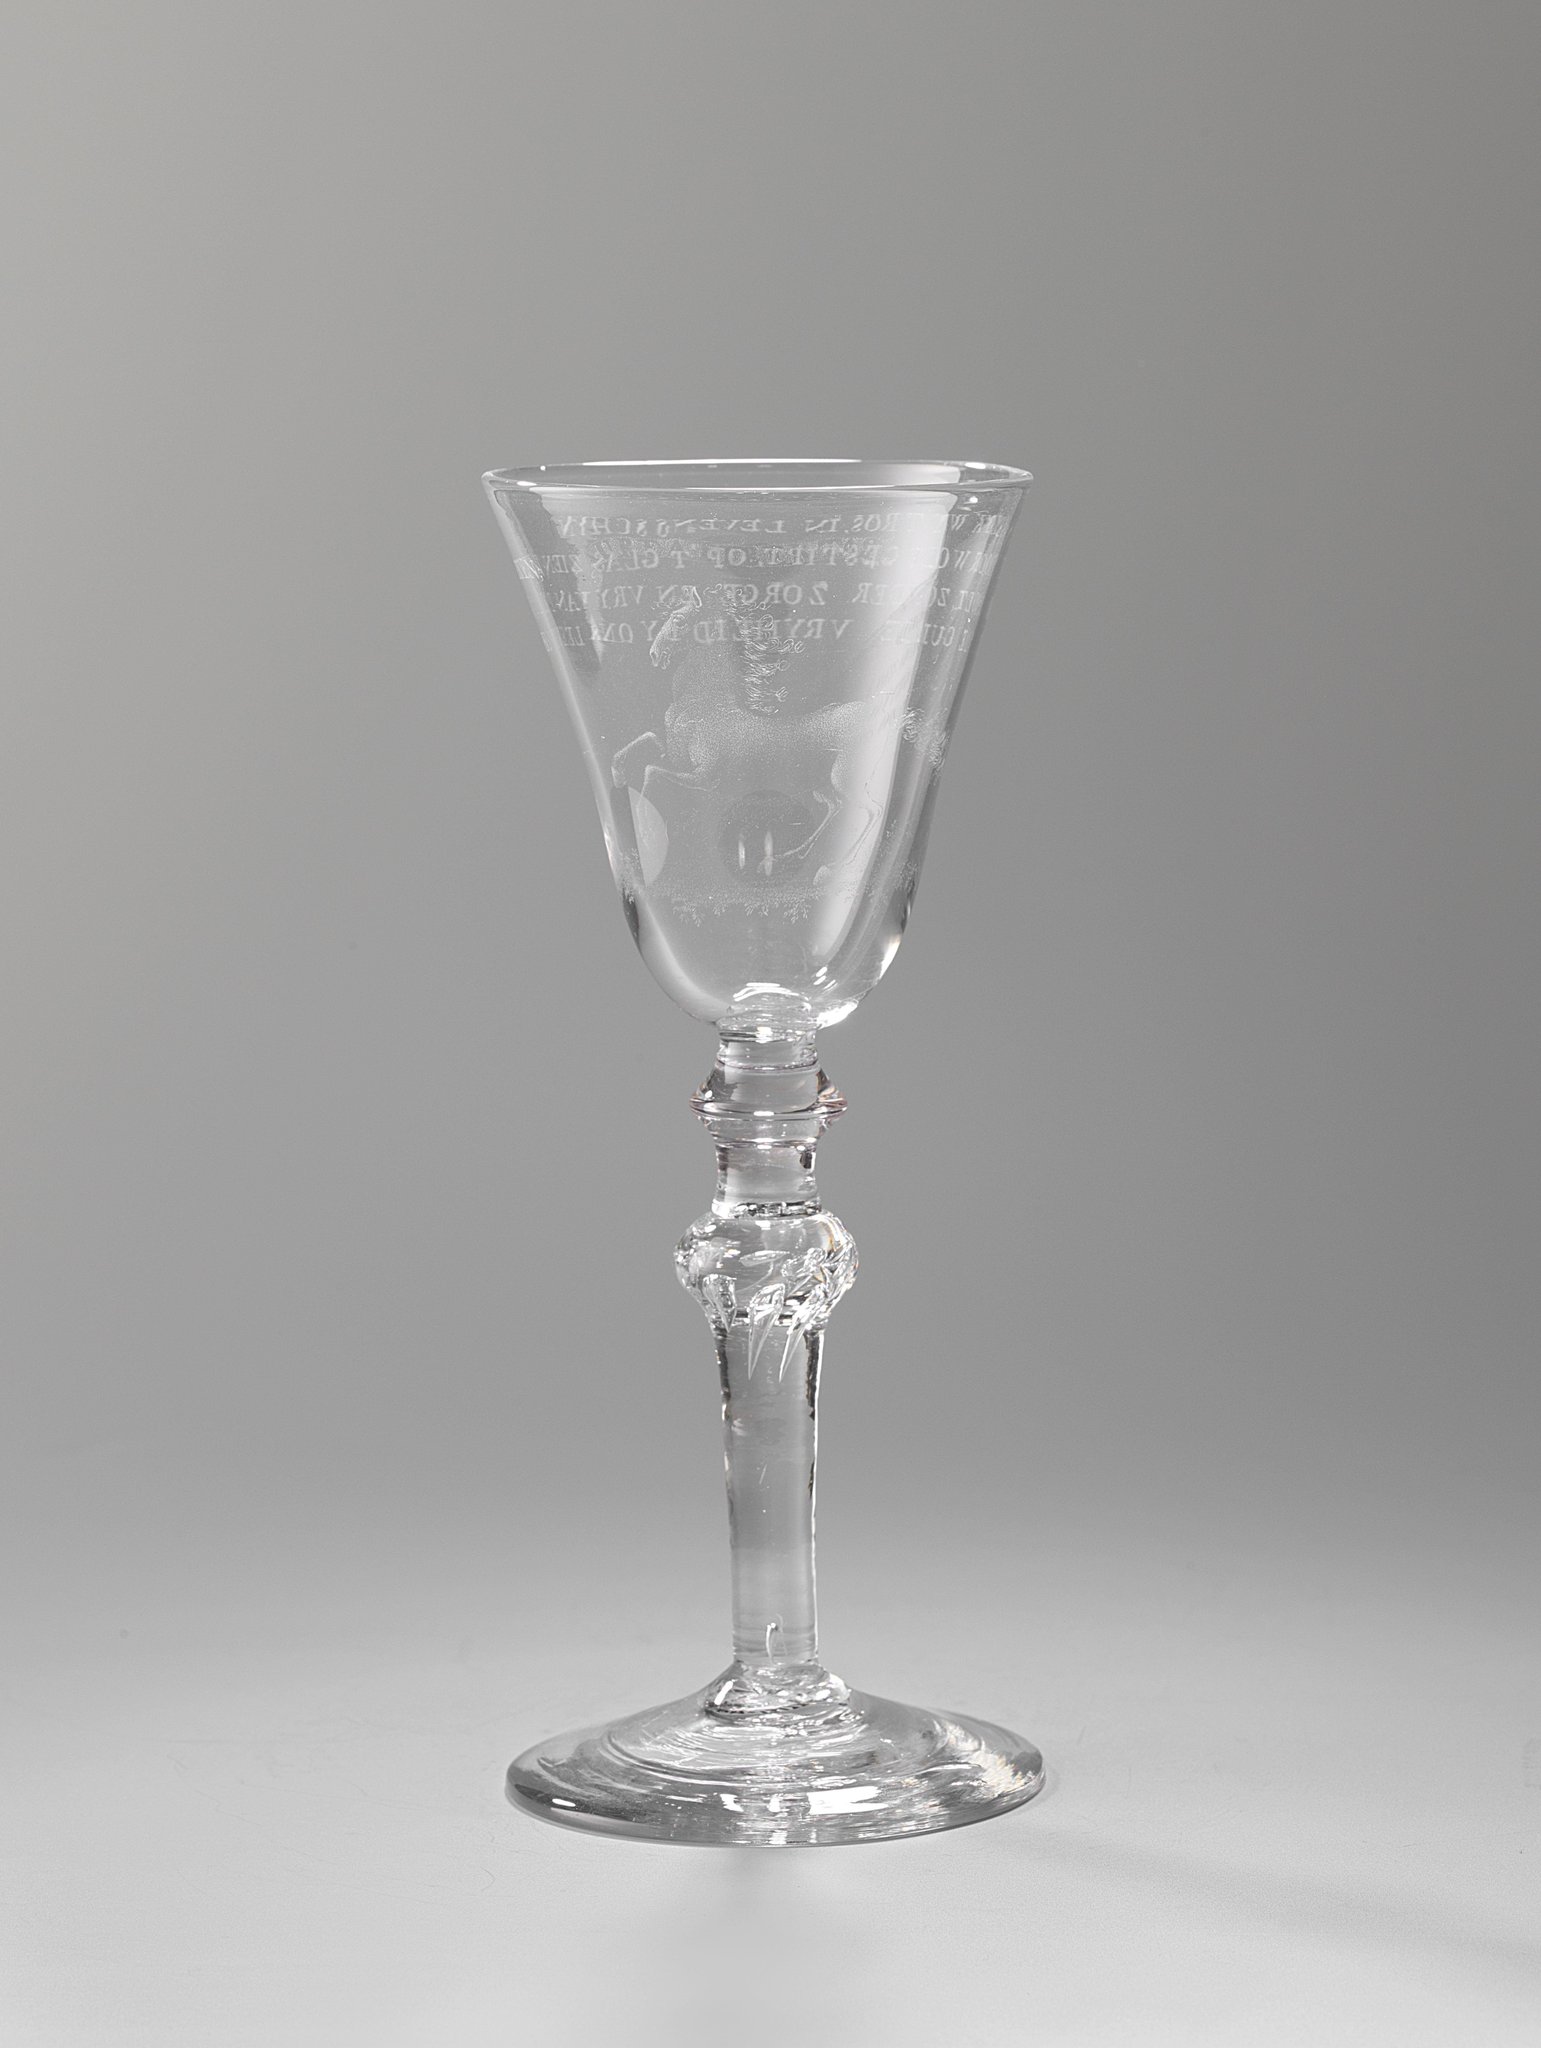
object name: goblet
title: Wine glass with a galloping horse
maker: Anonymous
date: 1795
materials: glass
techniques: diamond point engraving, glassblowing, engraving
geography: northern netherlands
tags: galloping horse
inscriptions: inscription, inscription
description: translation of inscription: Golden Freedom / Just as we see the life-like horse. Stippled by Wolf free-floating on the glass; thus carefree and free of pain, golden freedom must live with us!